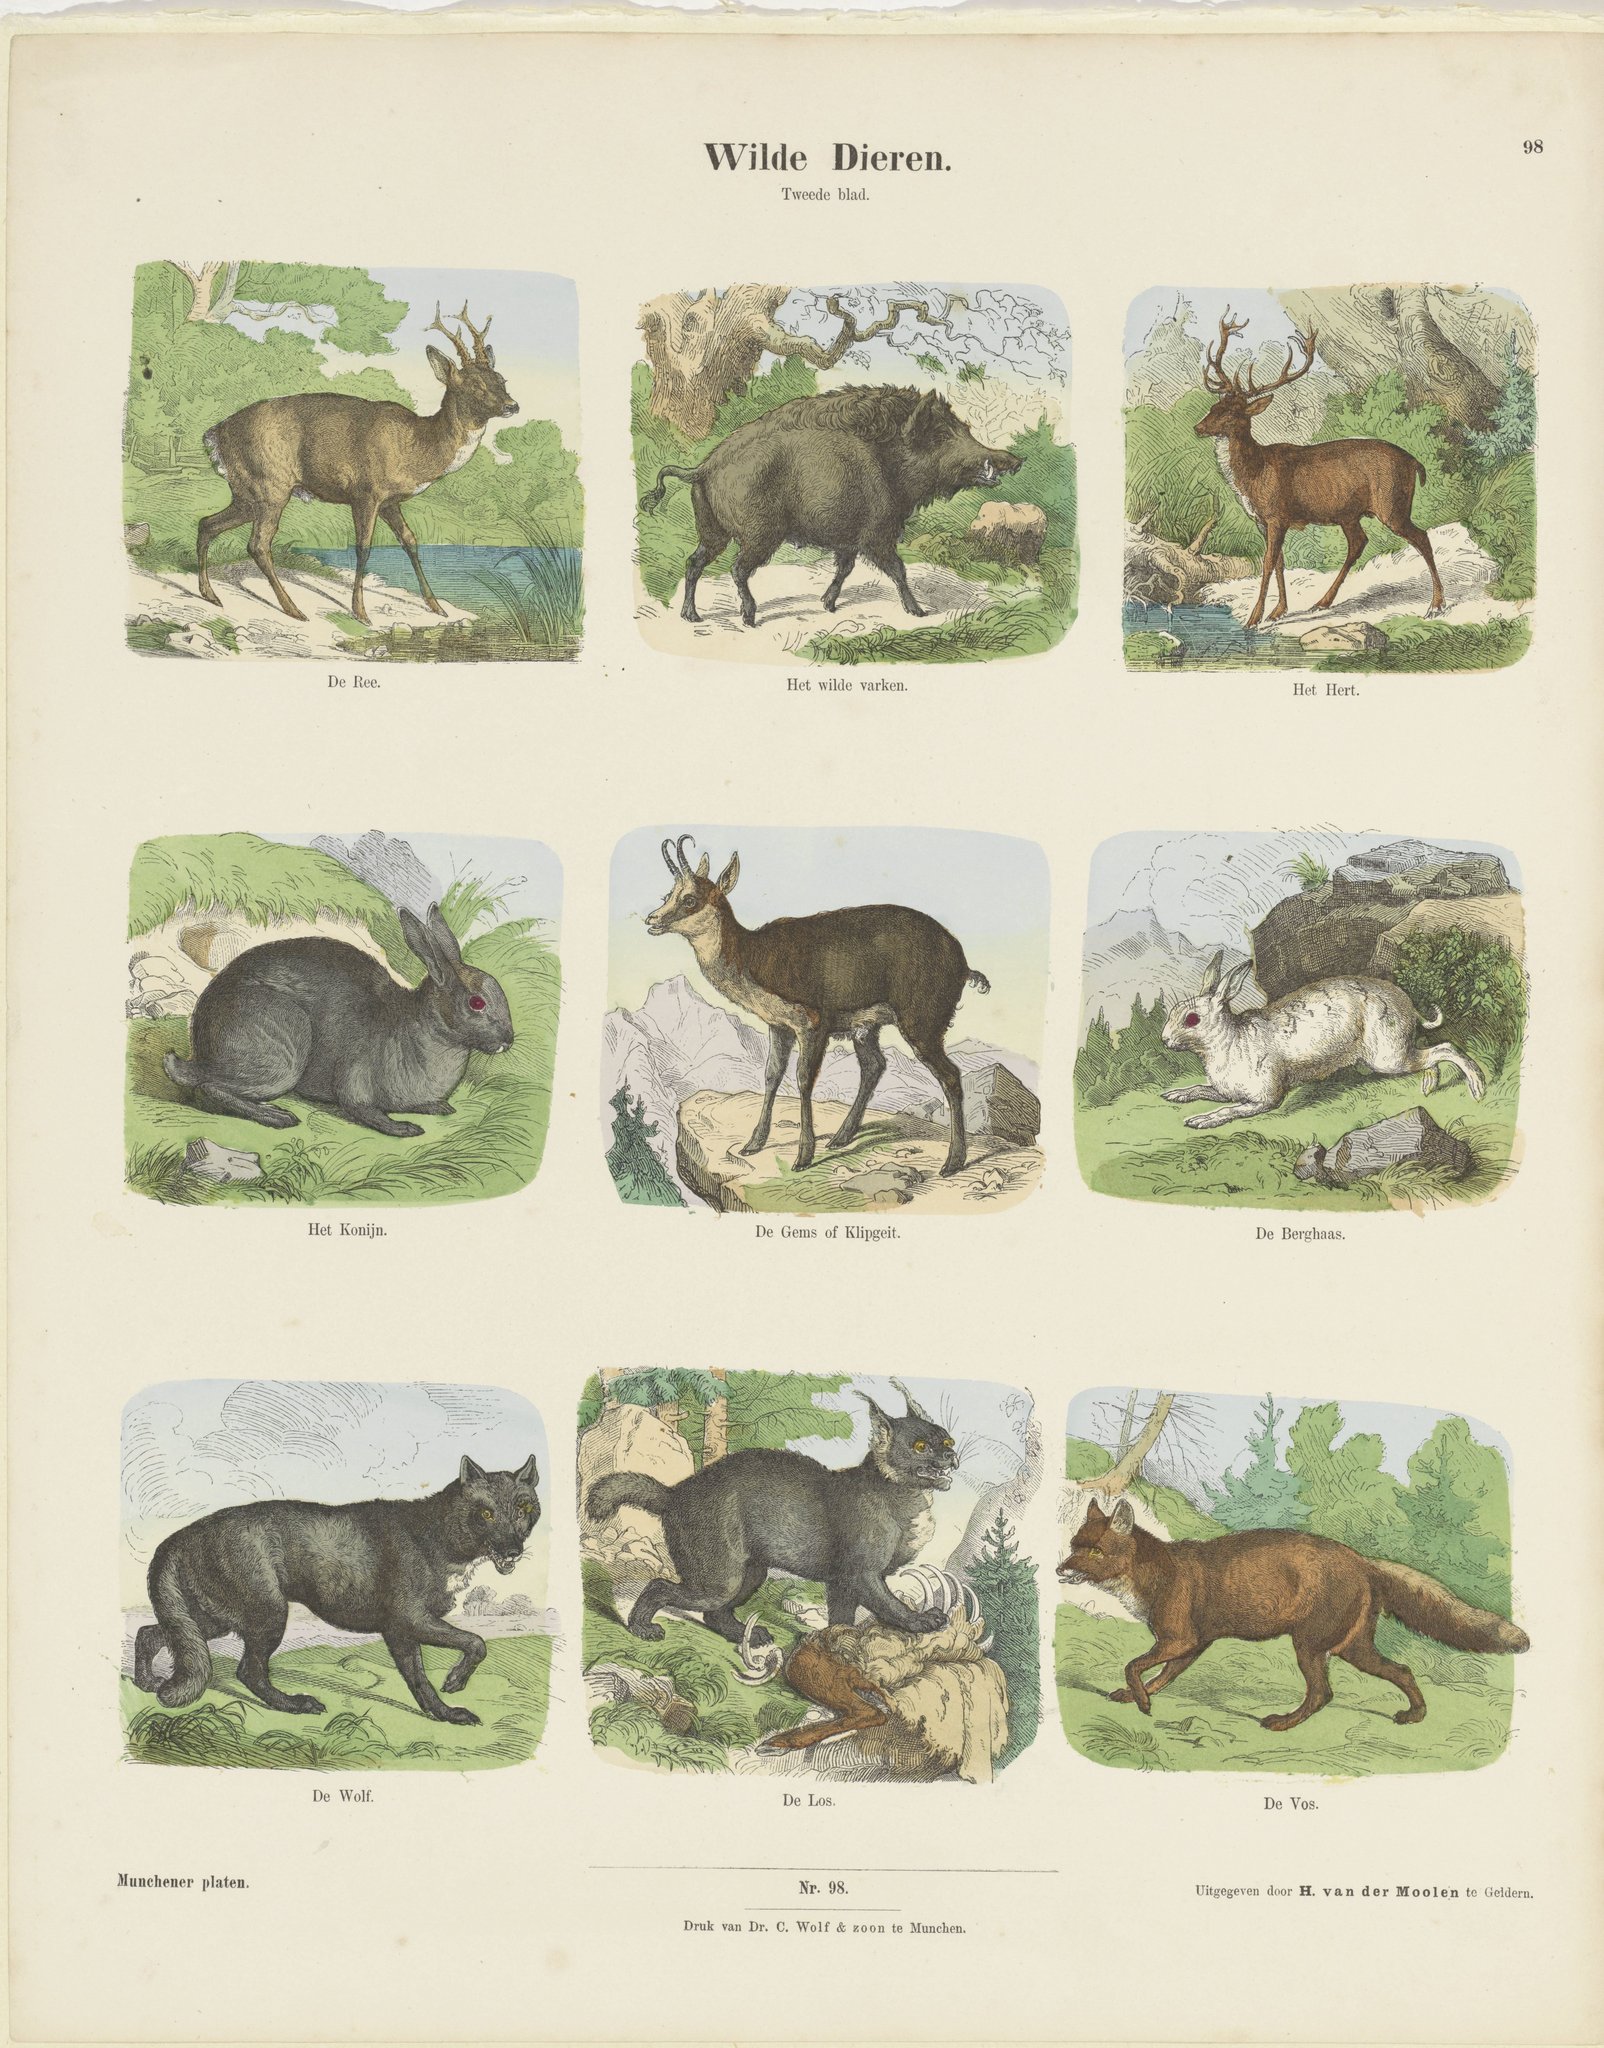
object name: print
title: Munchener platen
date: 1843-1920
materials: paper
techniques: colour, letterpress printing, engraving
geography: munich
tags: hoofed animals: deer, animals, hoofed animals: deer - ff - fabulous animals (sometimes wrongly called 'grotesques'); 'mostri' (ripa), hoofed animals: boar, rodents: rabbit, beasts of prey, predatory animals: wolf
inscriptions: collector's mark: Lugt 2760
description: Blad met 9 voorstellingen van dieren, waaronder een ree, een everzwijn, een konijn en een wolf. Onder elke afbeelding een onderschrift. Genummerd midden onder: Nro. 98. Genummerd rechtsboven: 98.